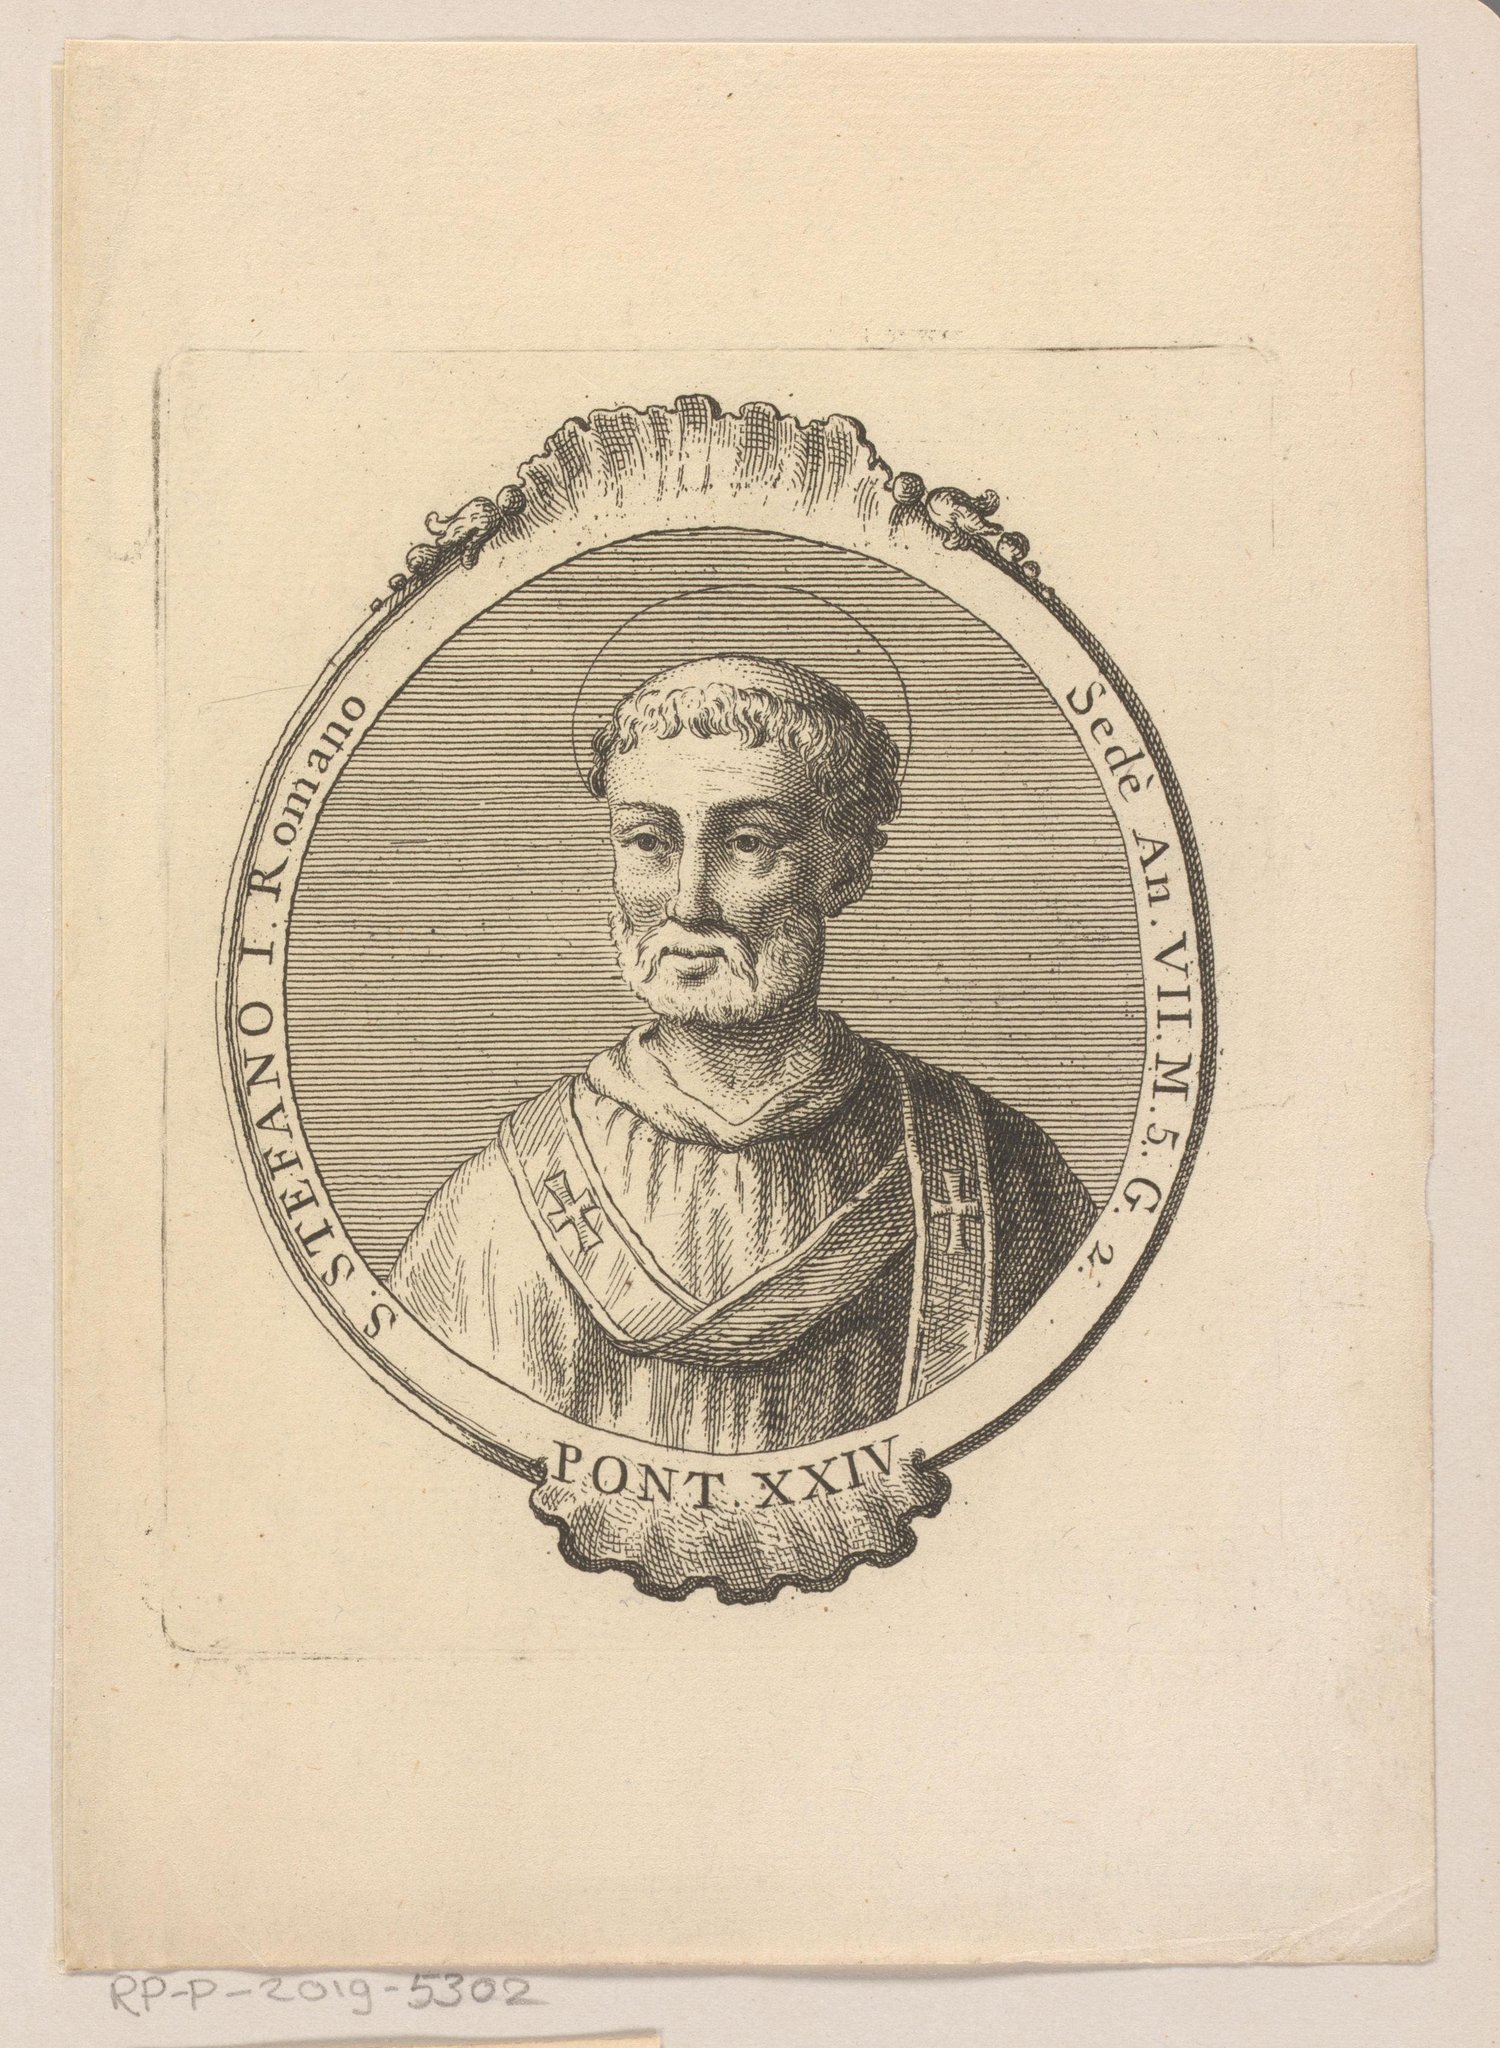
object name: print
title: Portret van paus Stefanus I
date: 1775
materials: paper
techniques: engraving, etching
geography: bassano del grappa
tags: rome, historical persons, pope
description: Prent uit: Effigies Romanorum pontificum a S. Petro ad Pium VI. feliciter regnantem (...). 2 dln. Venetië en Bassano del Grappa: Giuseppe Remondini, 1775.